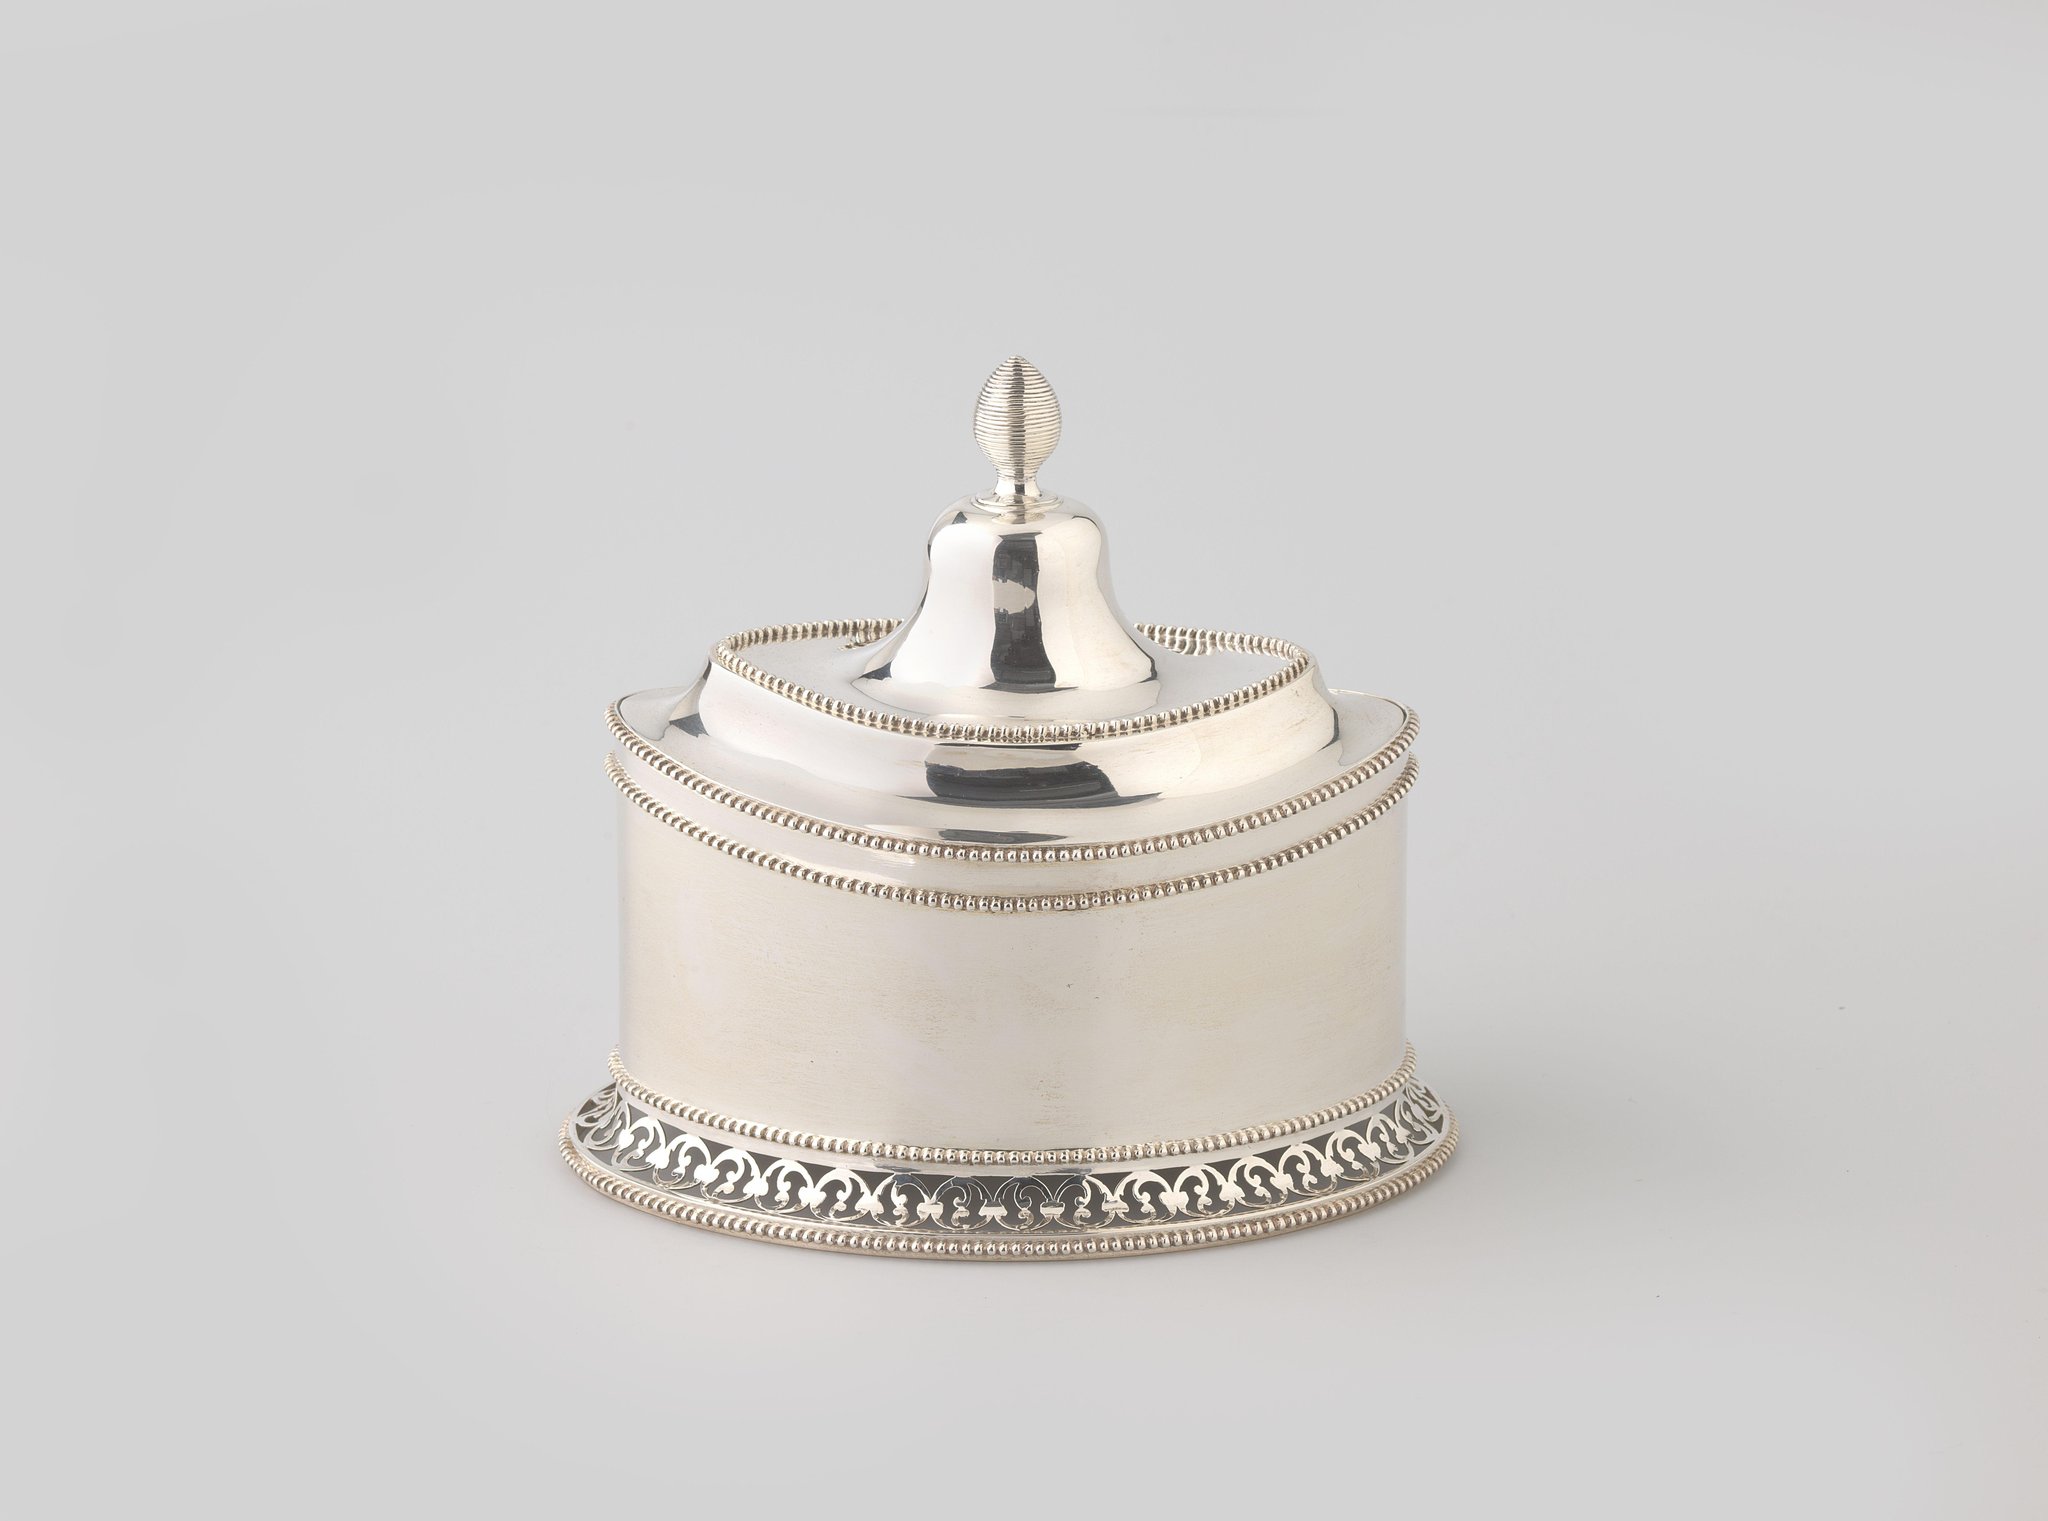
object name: tobacco jar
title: Tabakspot, ovaal, met parellijsten en opengewerkte plint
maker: hendrik smits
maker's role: silversmith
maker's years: 1772-1841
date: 1800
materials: silver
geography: amsterdam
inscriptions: town mark, maker's mark, date letter: ‘R’, alloy mark, retailer's mark: ‘DIEMONT’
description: Tobacco jar. Silver. Amsterdam, 1800, by Willem Diemont, made by Hendrik Smits.